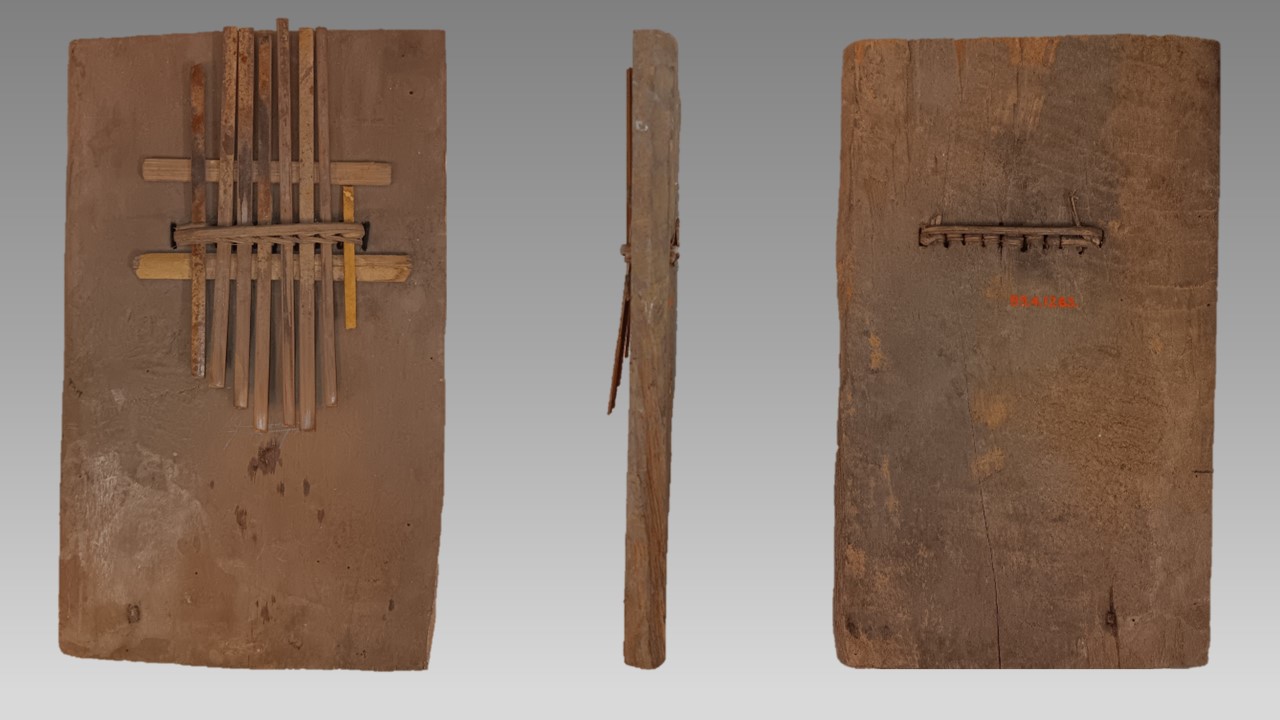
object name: zanze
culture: cameroonian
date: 1867-1900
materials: wood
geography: cameroon